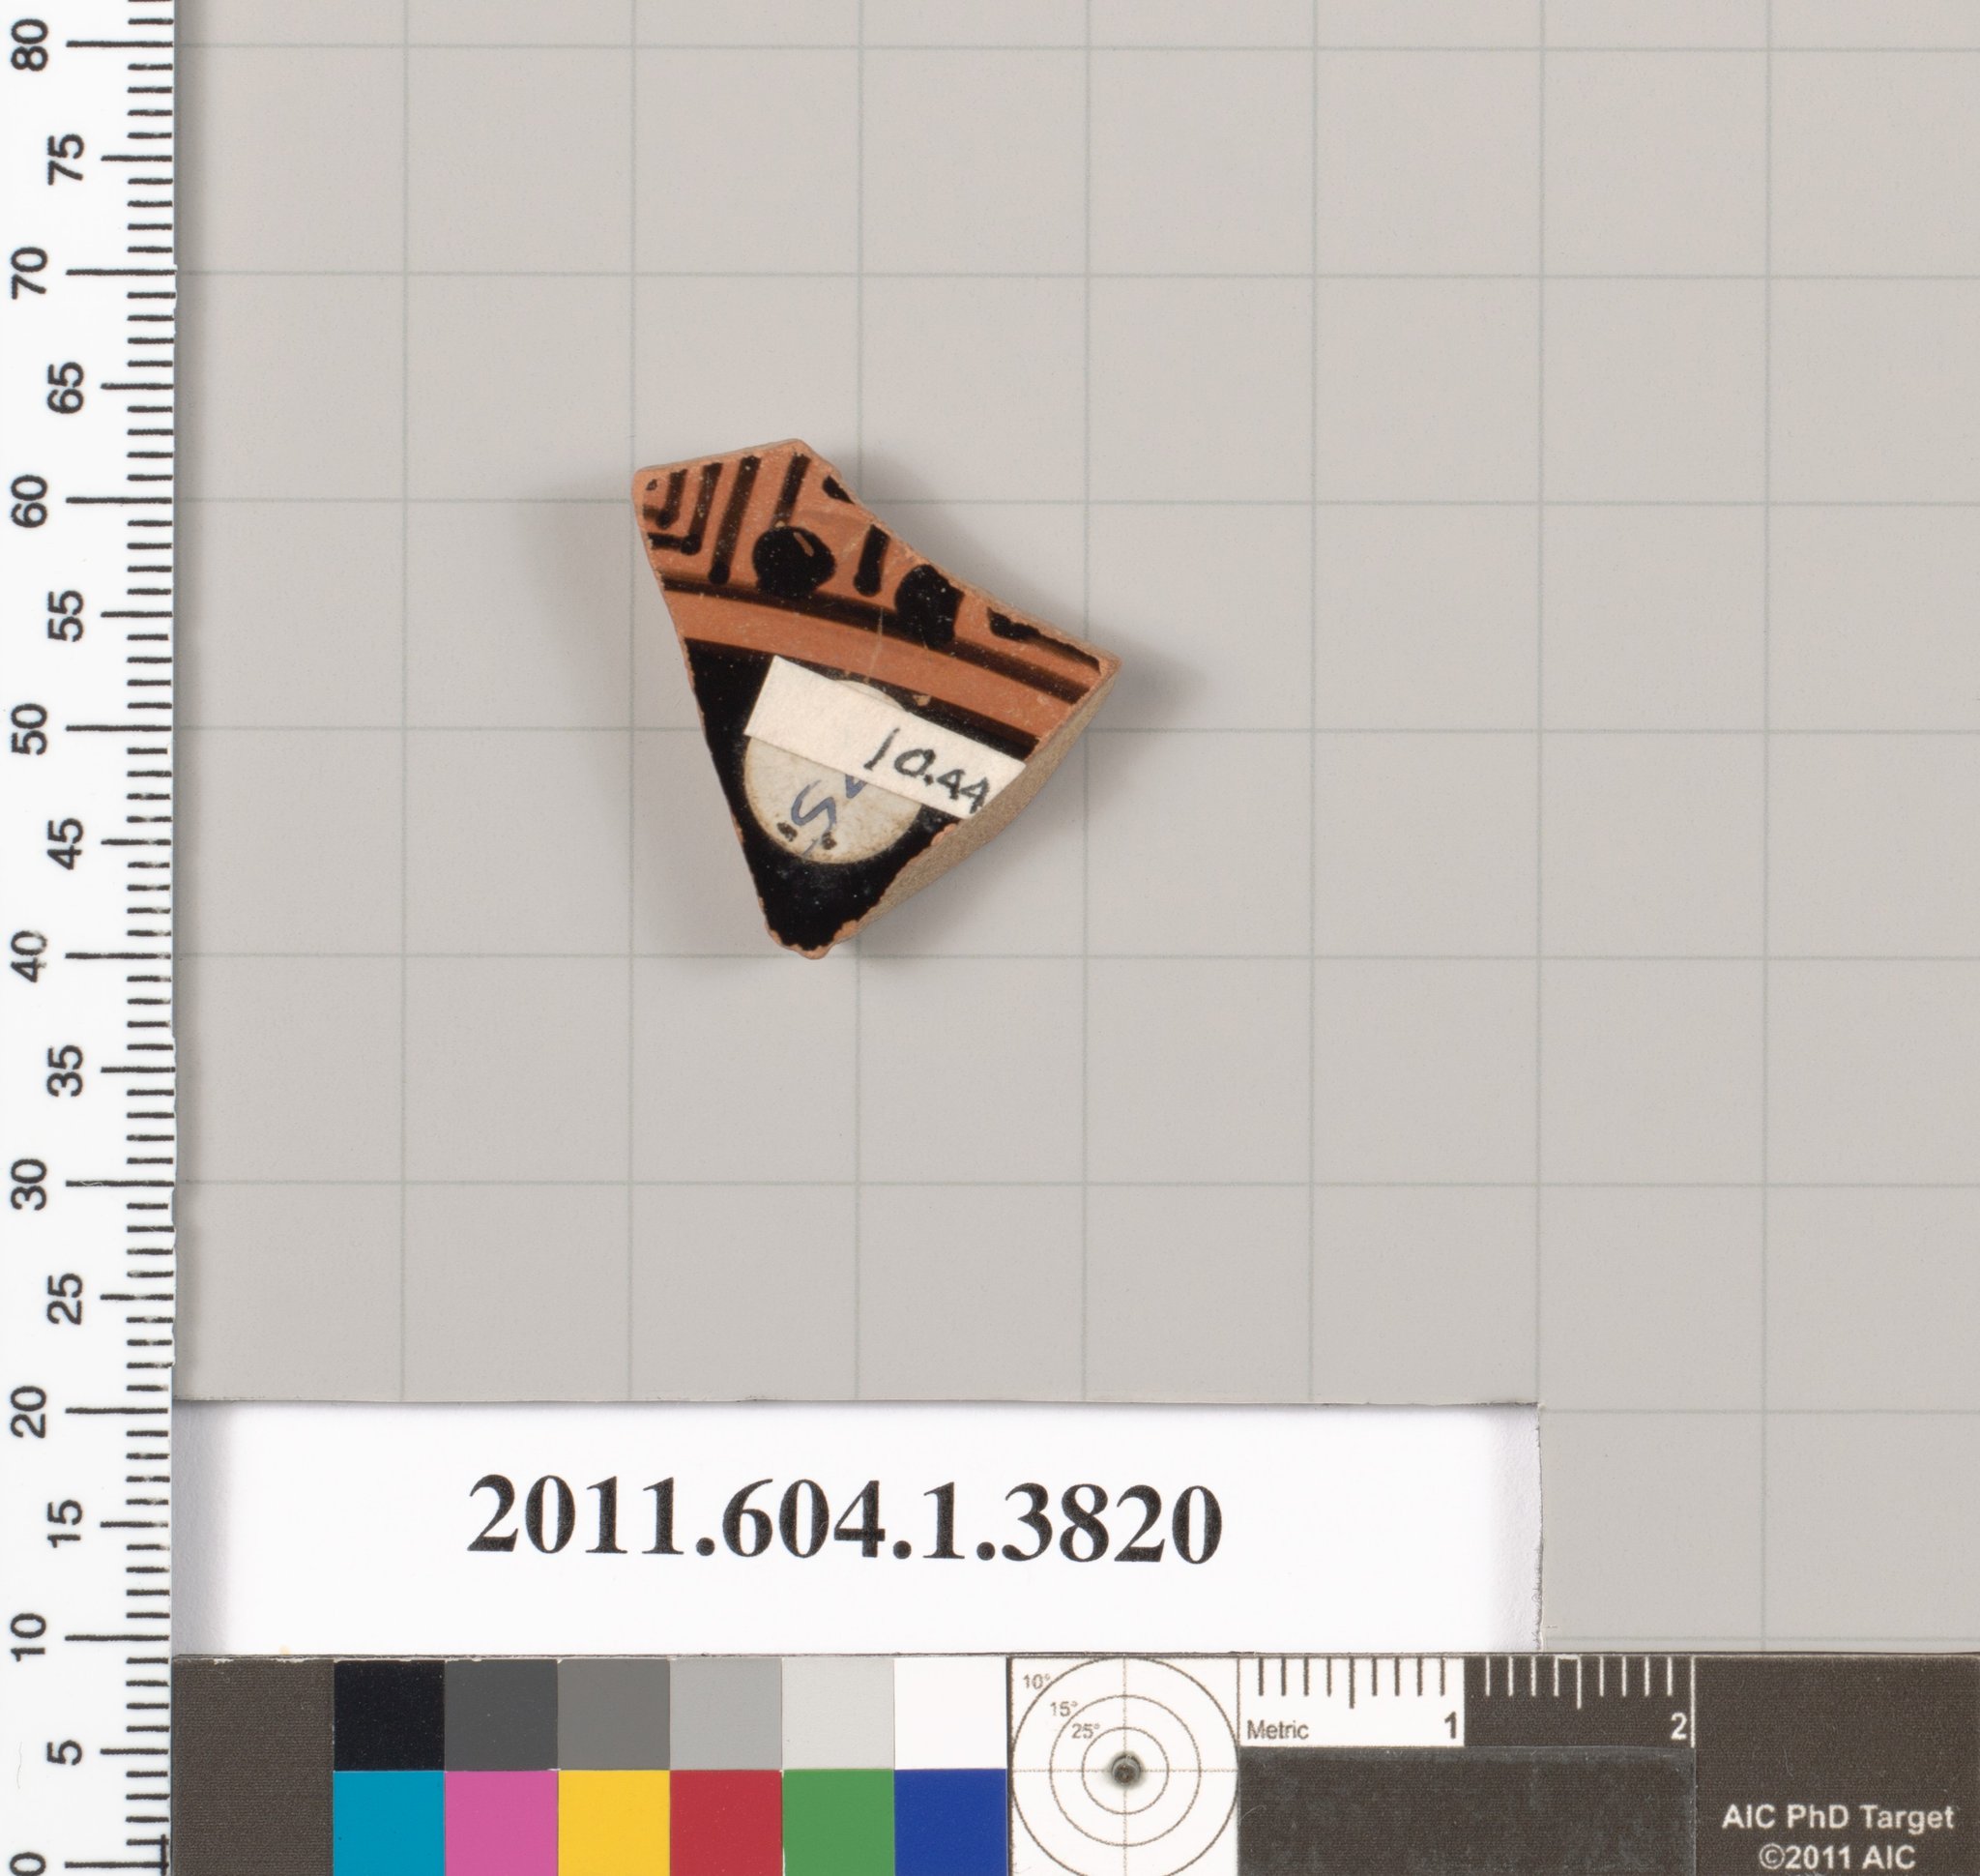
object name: kylix fragment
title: Terracotta fragment of a kylix (drinking cup)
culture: greek, attic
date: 475-451 BCE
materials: terracotta